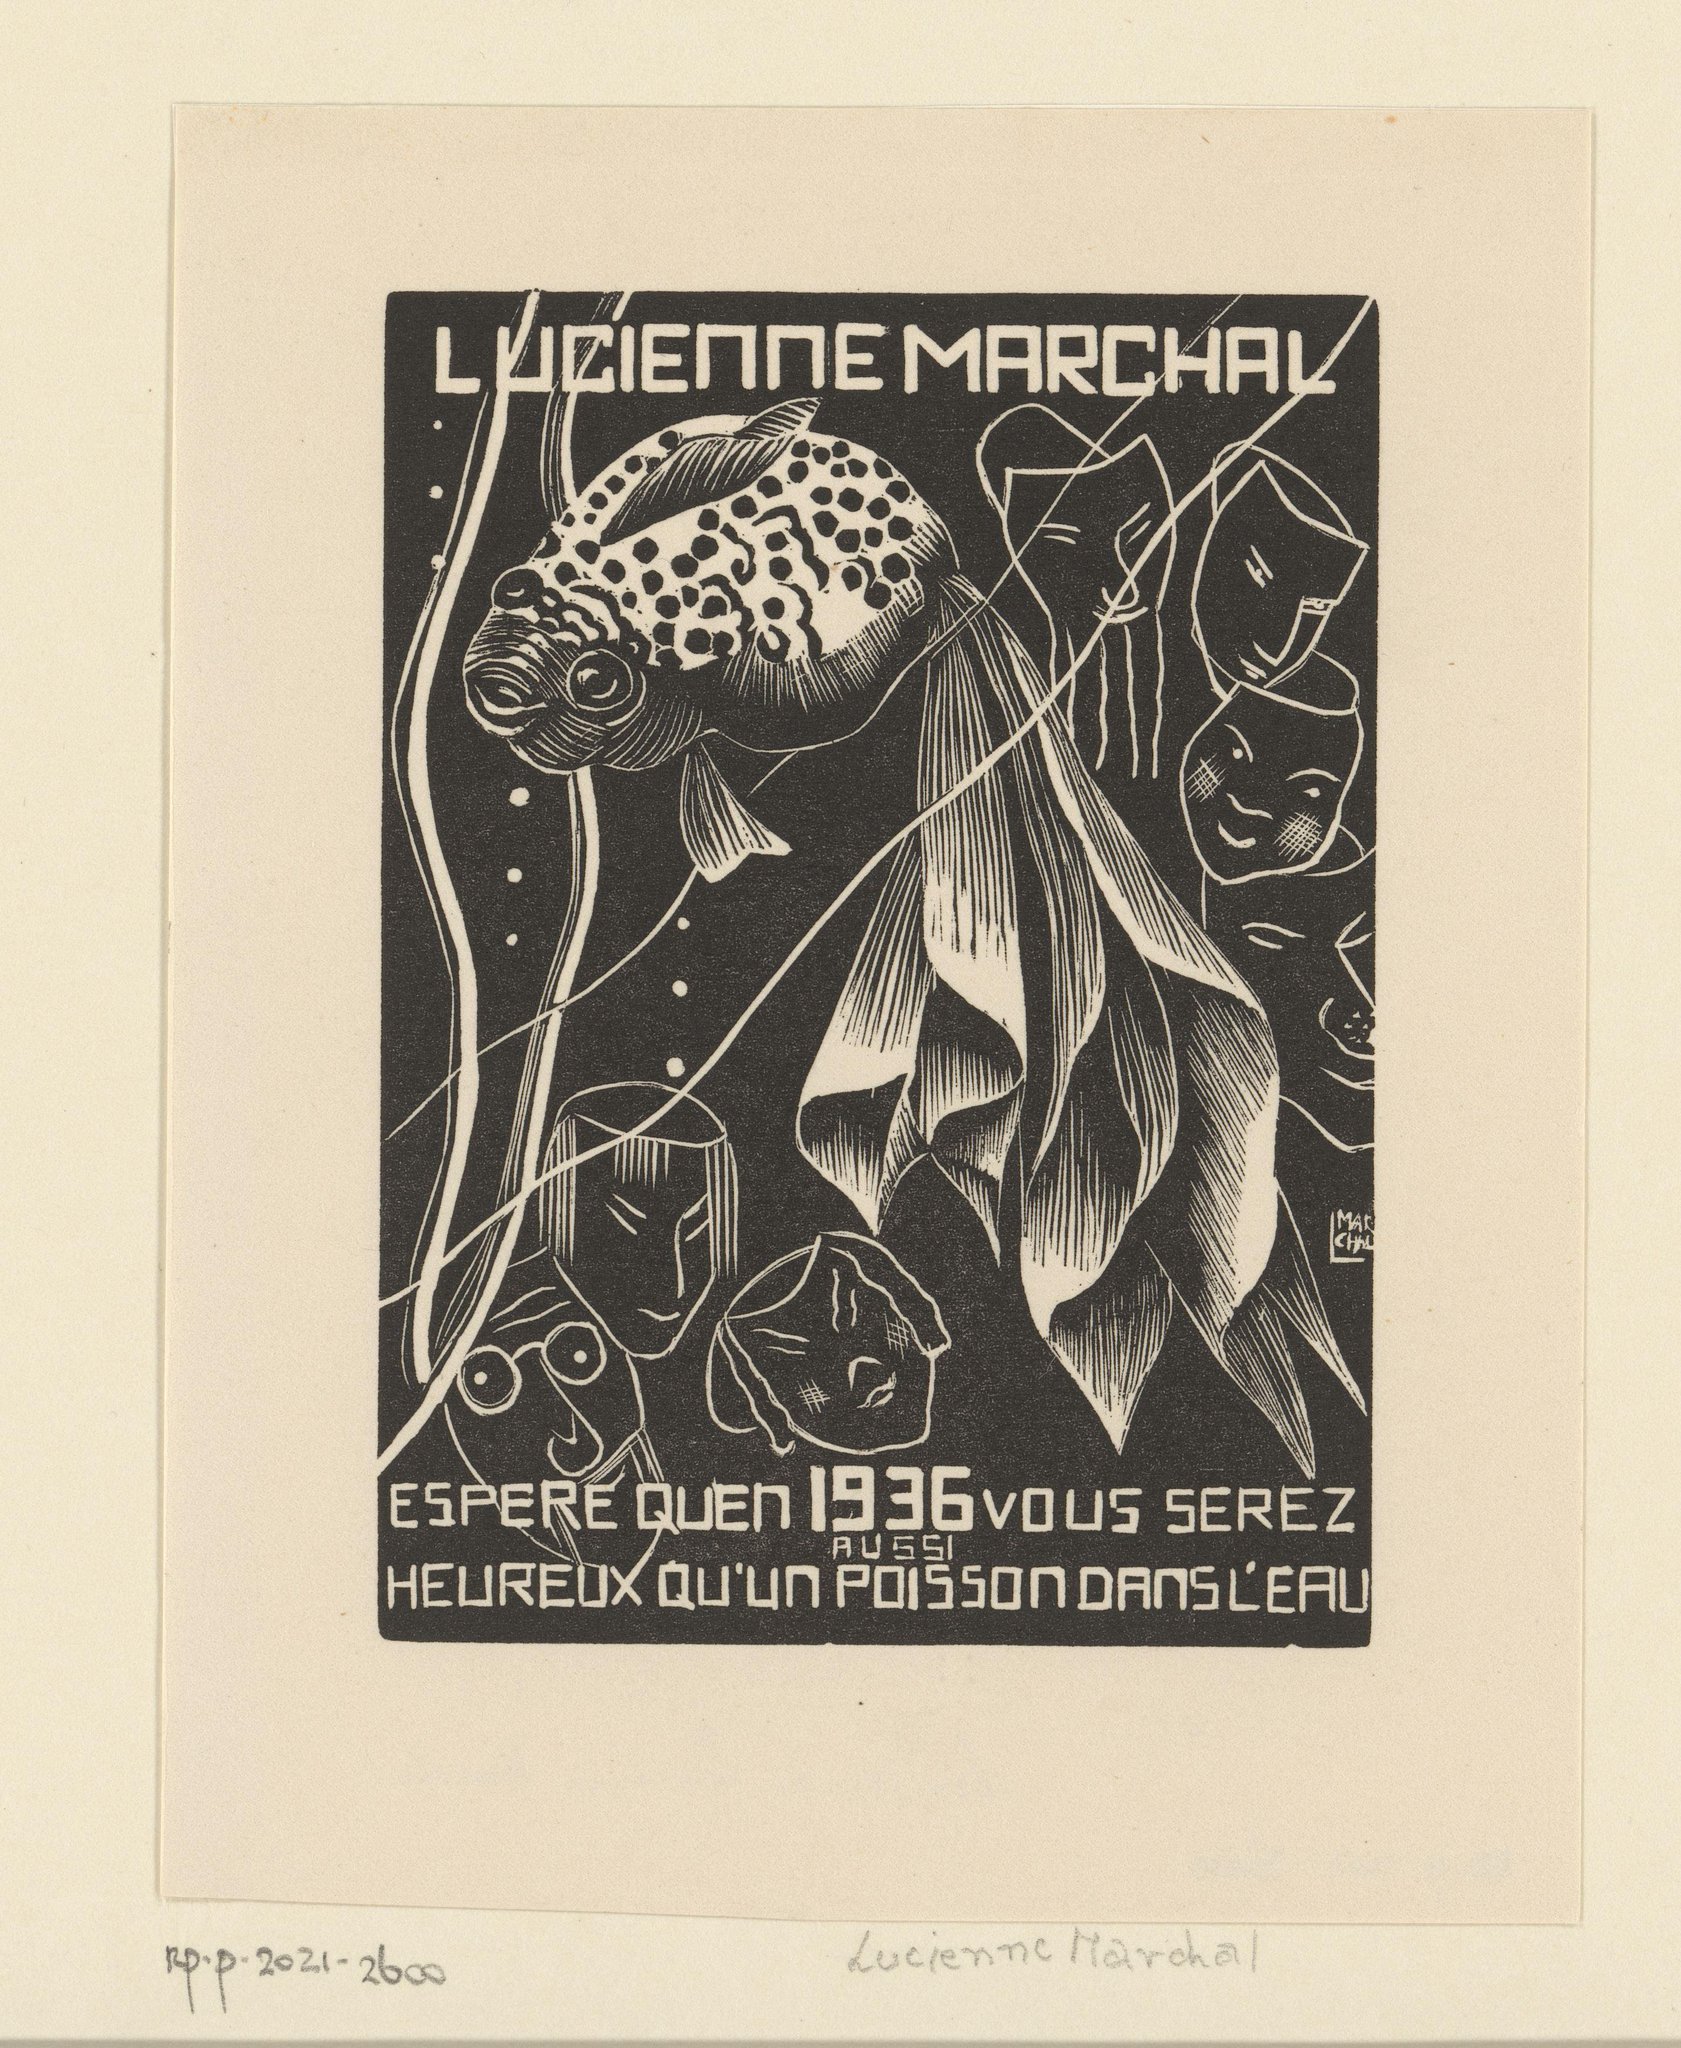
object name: new year card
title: Nieuwjaarswens voor 1936 van Lucienne Marchal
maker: lucienne marchal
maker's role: print maker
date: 1935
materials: paper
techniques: engraving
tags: print maker, lucienne marchal, mask, fishes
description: Voor de bepaling van de rechten van dit object is bij gebrek aan gegevens over de prentmaker gebruik gemaakt van de vervaardigingsdatum.